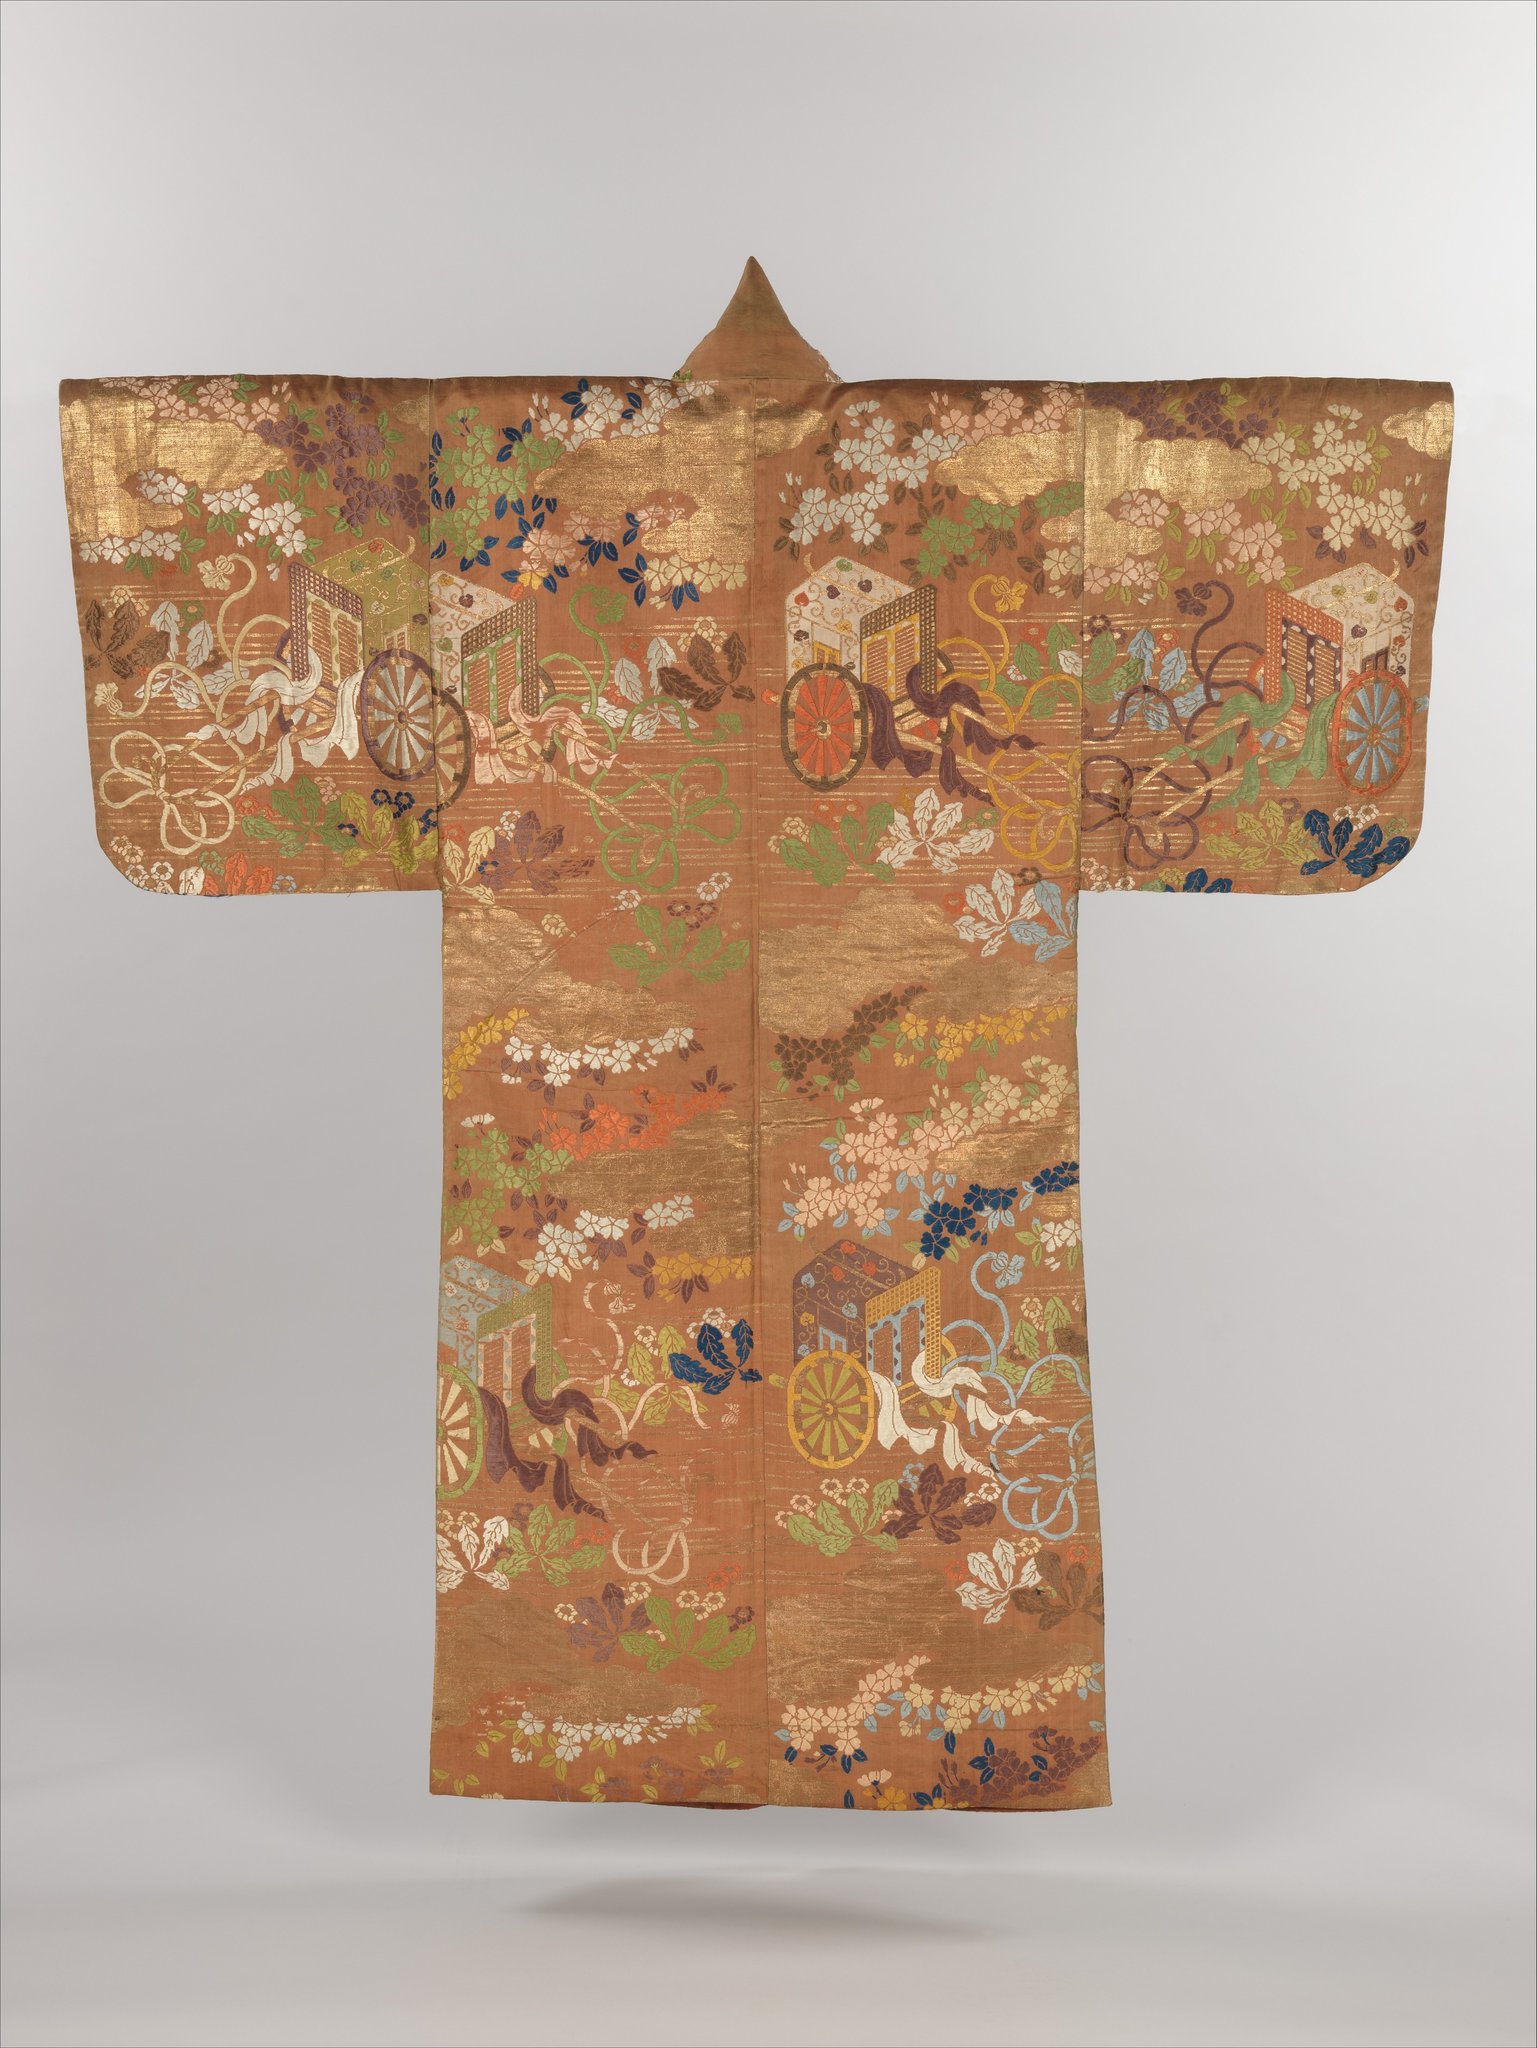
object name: noh costume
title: Noh Costume (Karaori) with Court Carriages, Cherry Blossoms, and Dandelions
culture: japanese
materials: metal thread, silk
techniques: brocade, patterning, weave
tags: carriages